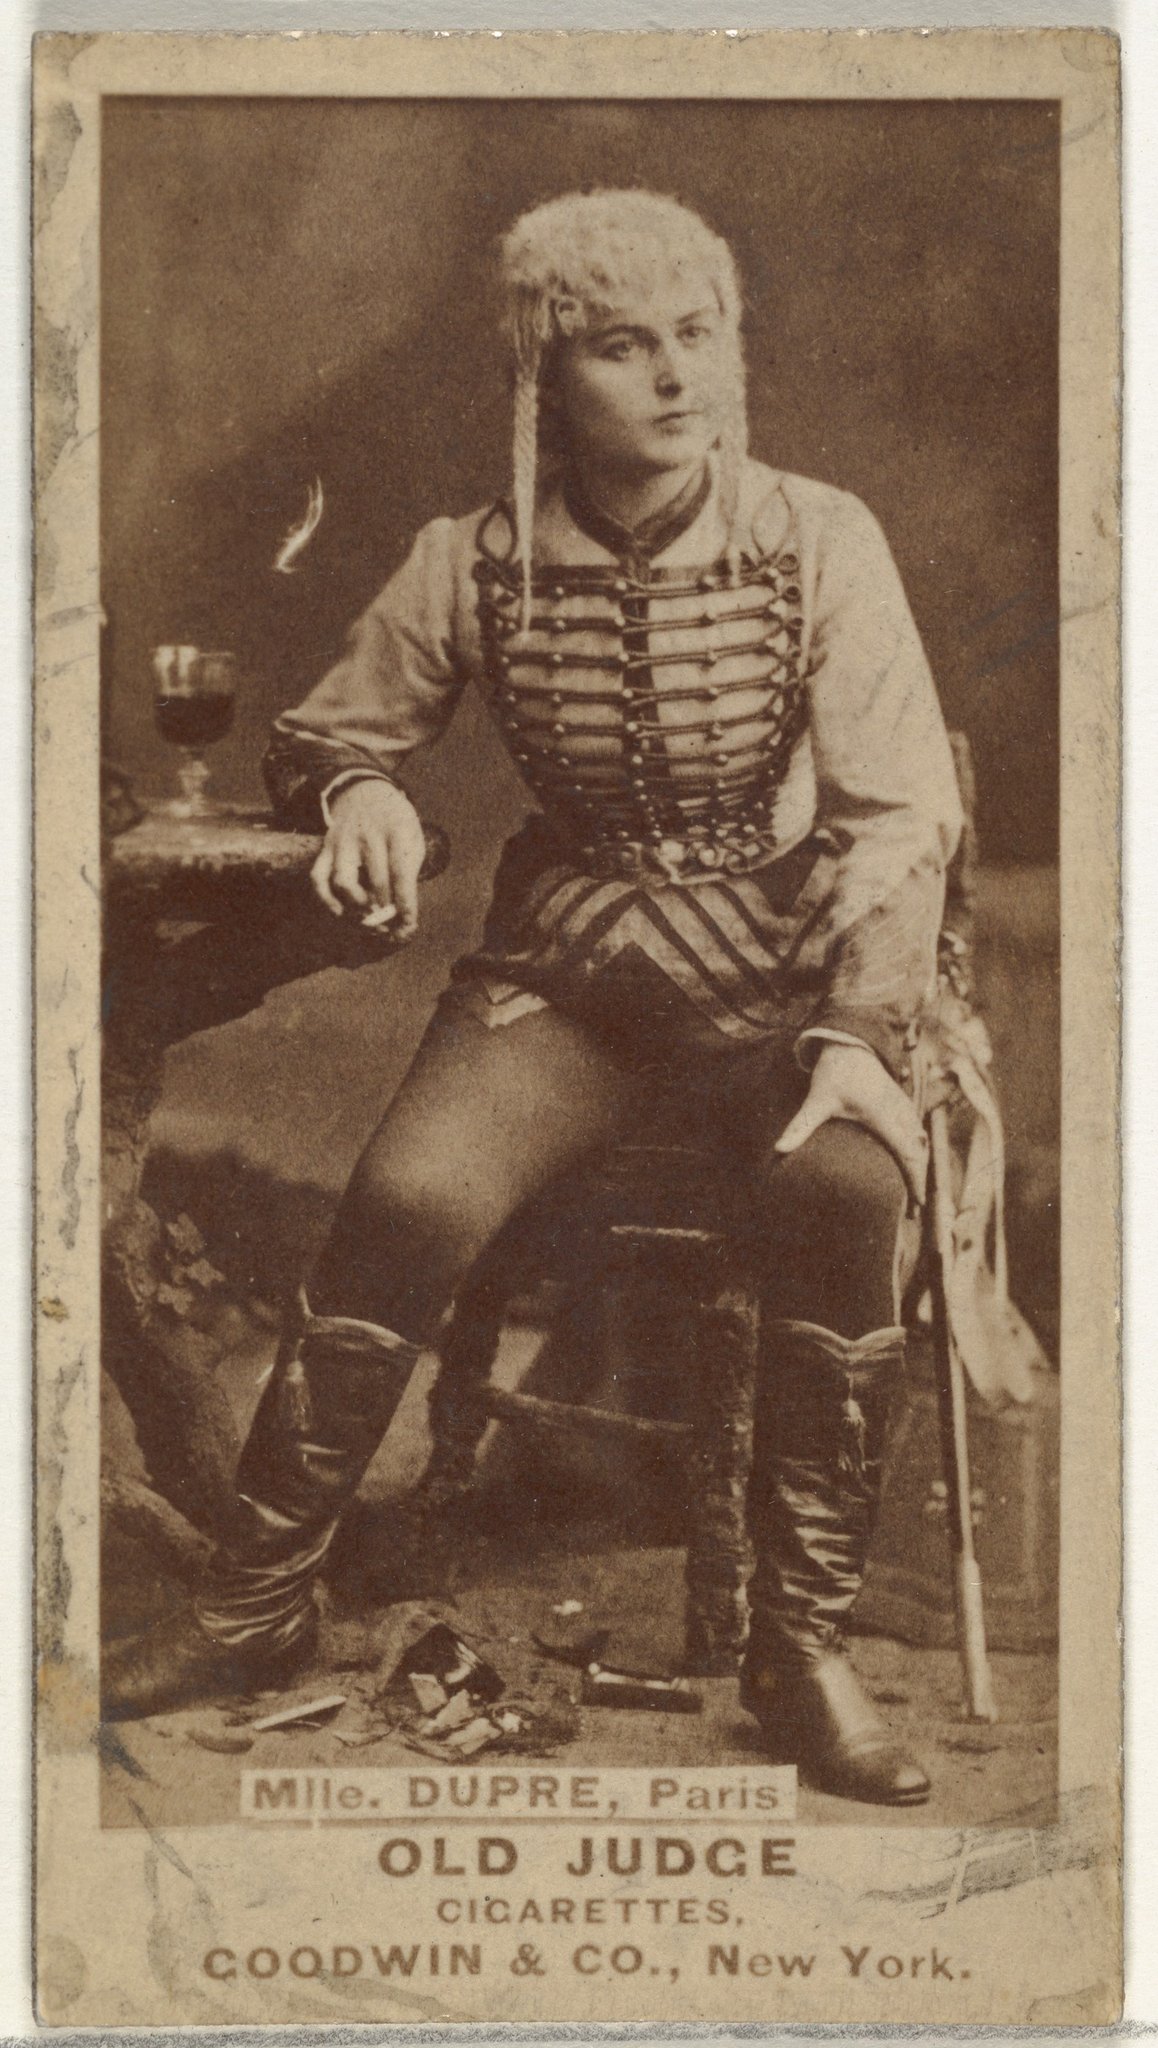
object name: photograph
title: Mlle. Dupre, Paris, from the Actors and Actresses series (N171) for Old Judge Cigarettes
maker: goodwin & company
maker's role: publisher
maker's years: 1850-1950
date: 1886-1890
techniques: albumen silver print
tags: portraits,women,actresses